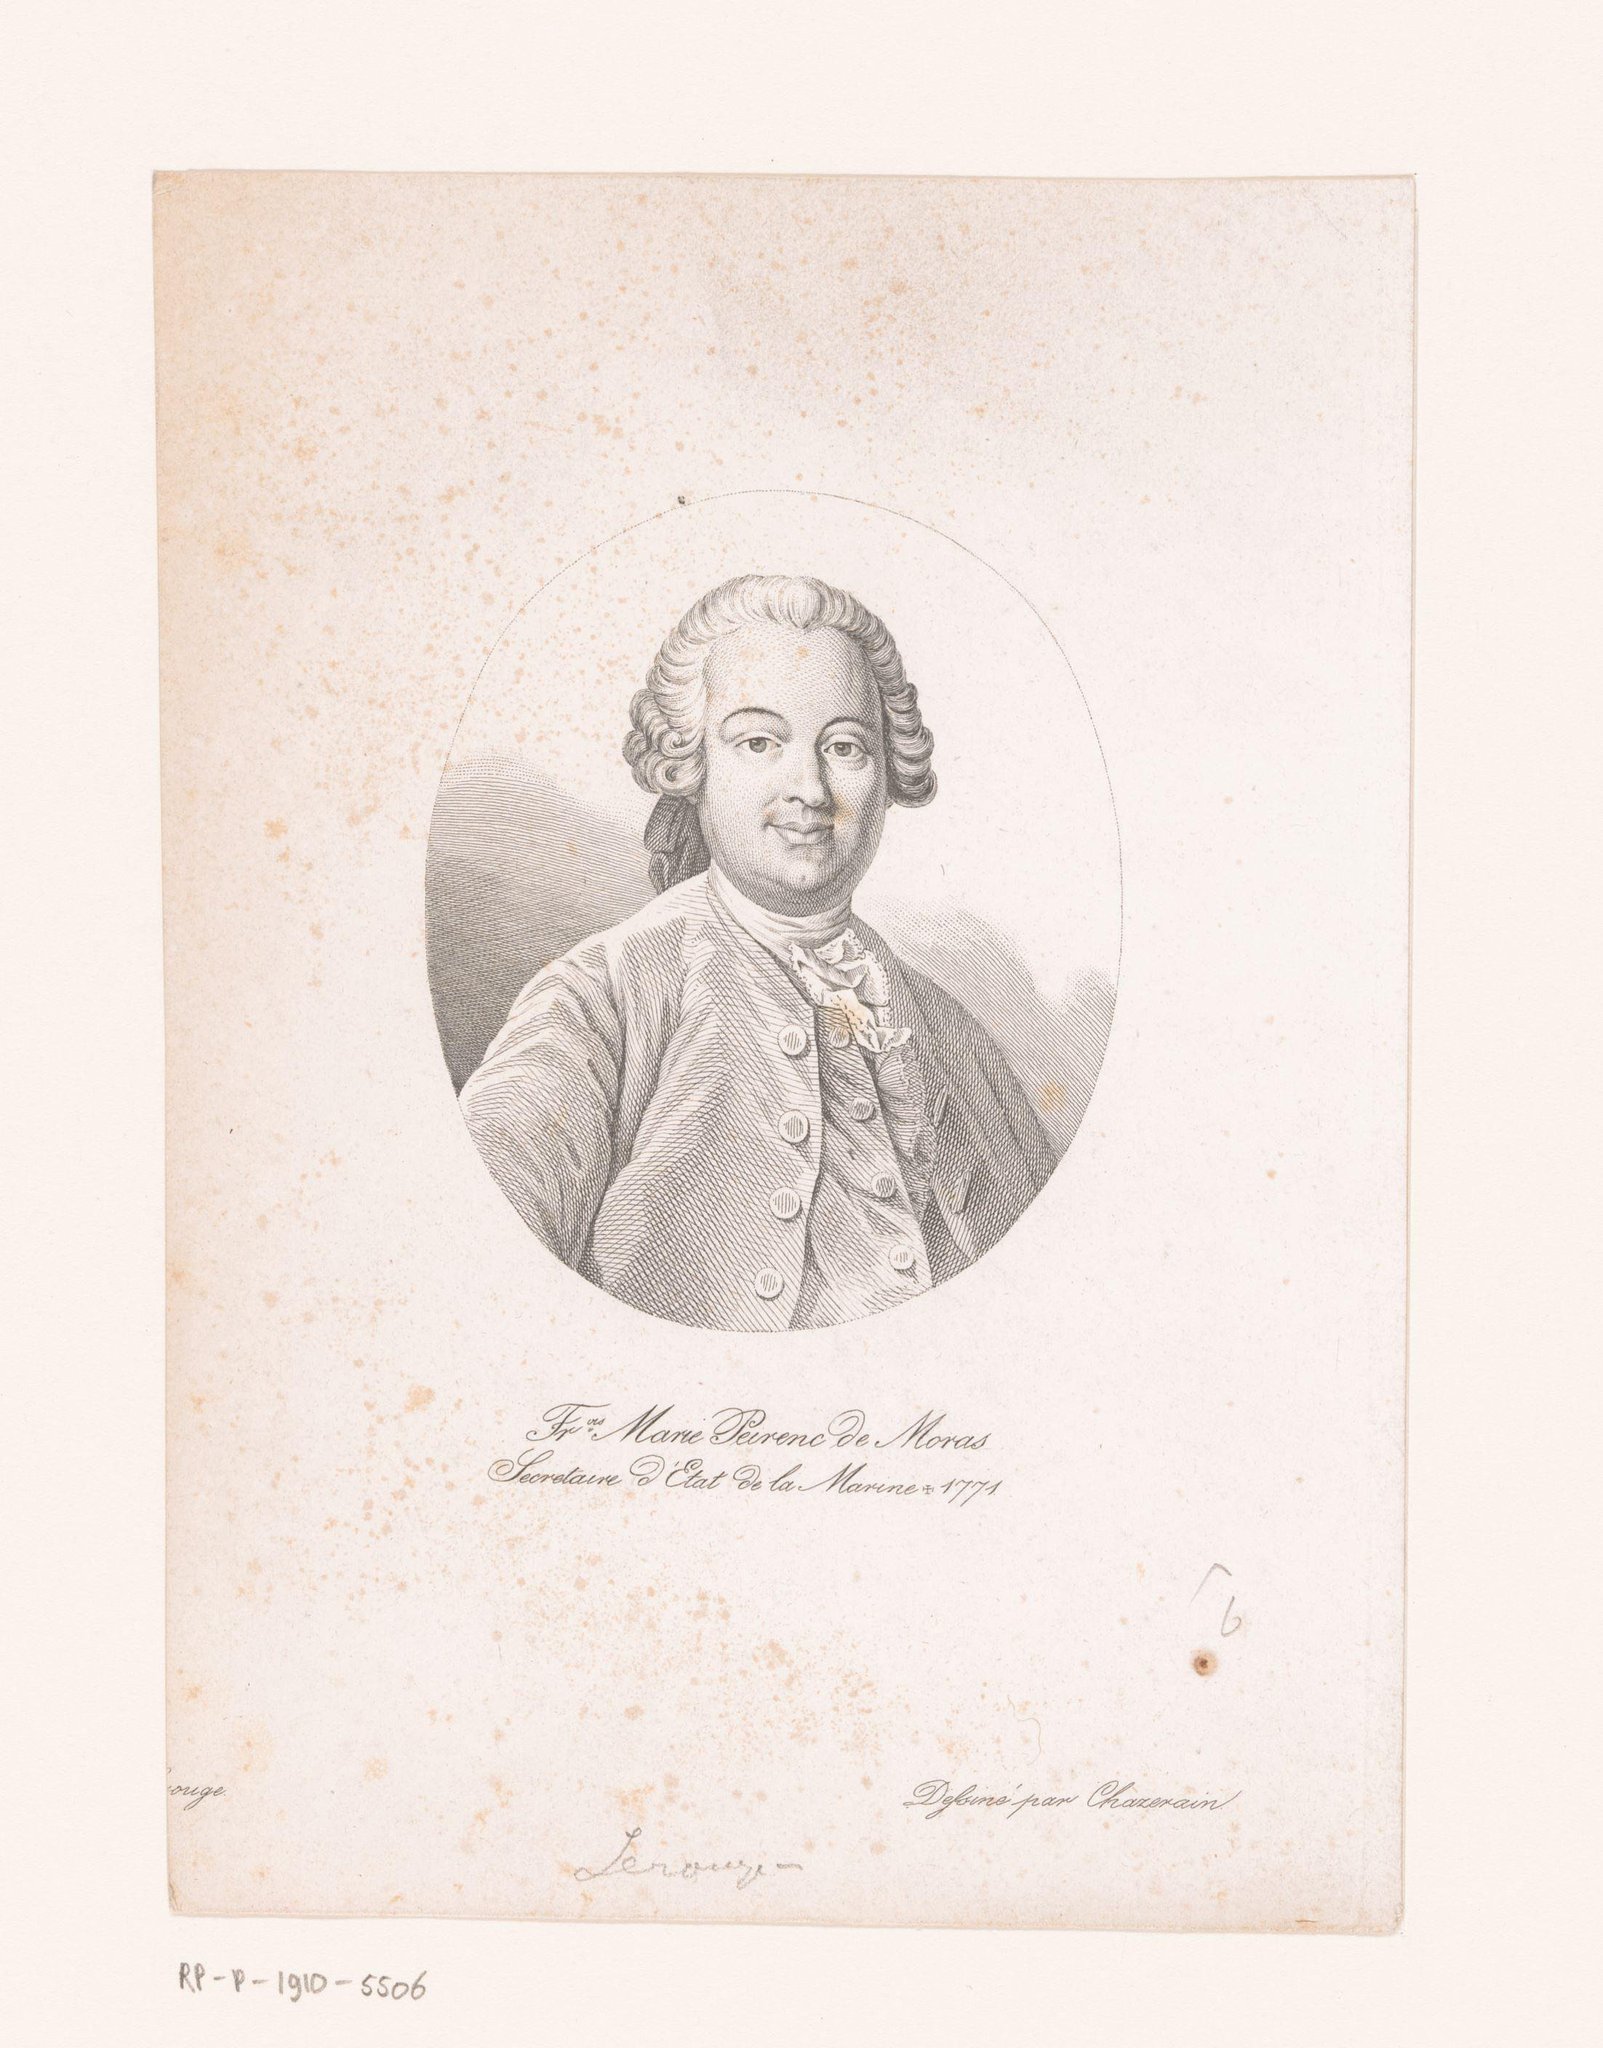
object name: print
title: Portret van François Marie Peyrenc de Moras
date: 1838-1841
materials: paper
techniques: engraving, etching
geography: paris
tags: historical persons, politician, e.g. party leader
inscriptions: collector's mark: Lugt 2228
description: Waarschijnlijk prent uit: Galeries historiques de Versailles. Parijs: Charles Gavard, 1838-1841.